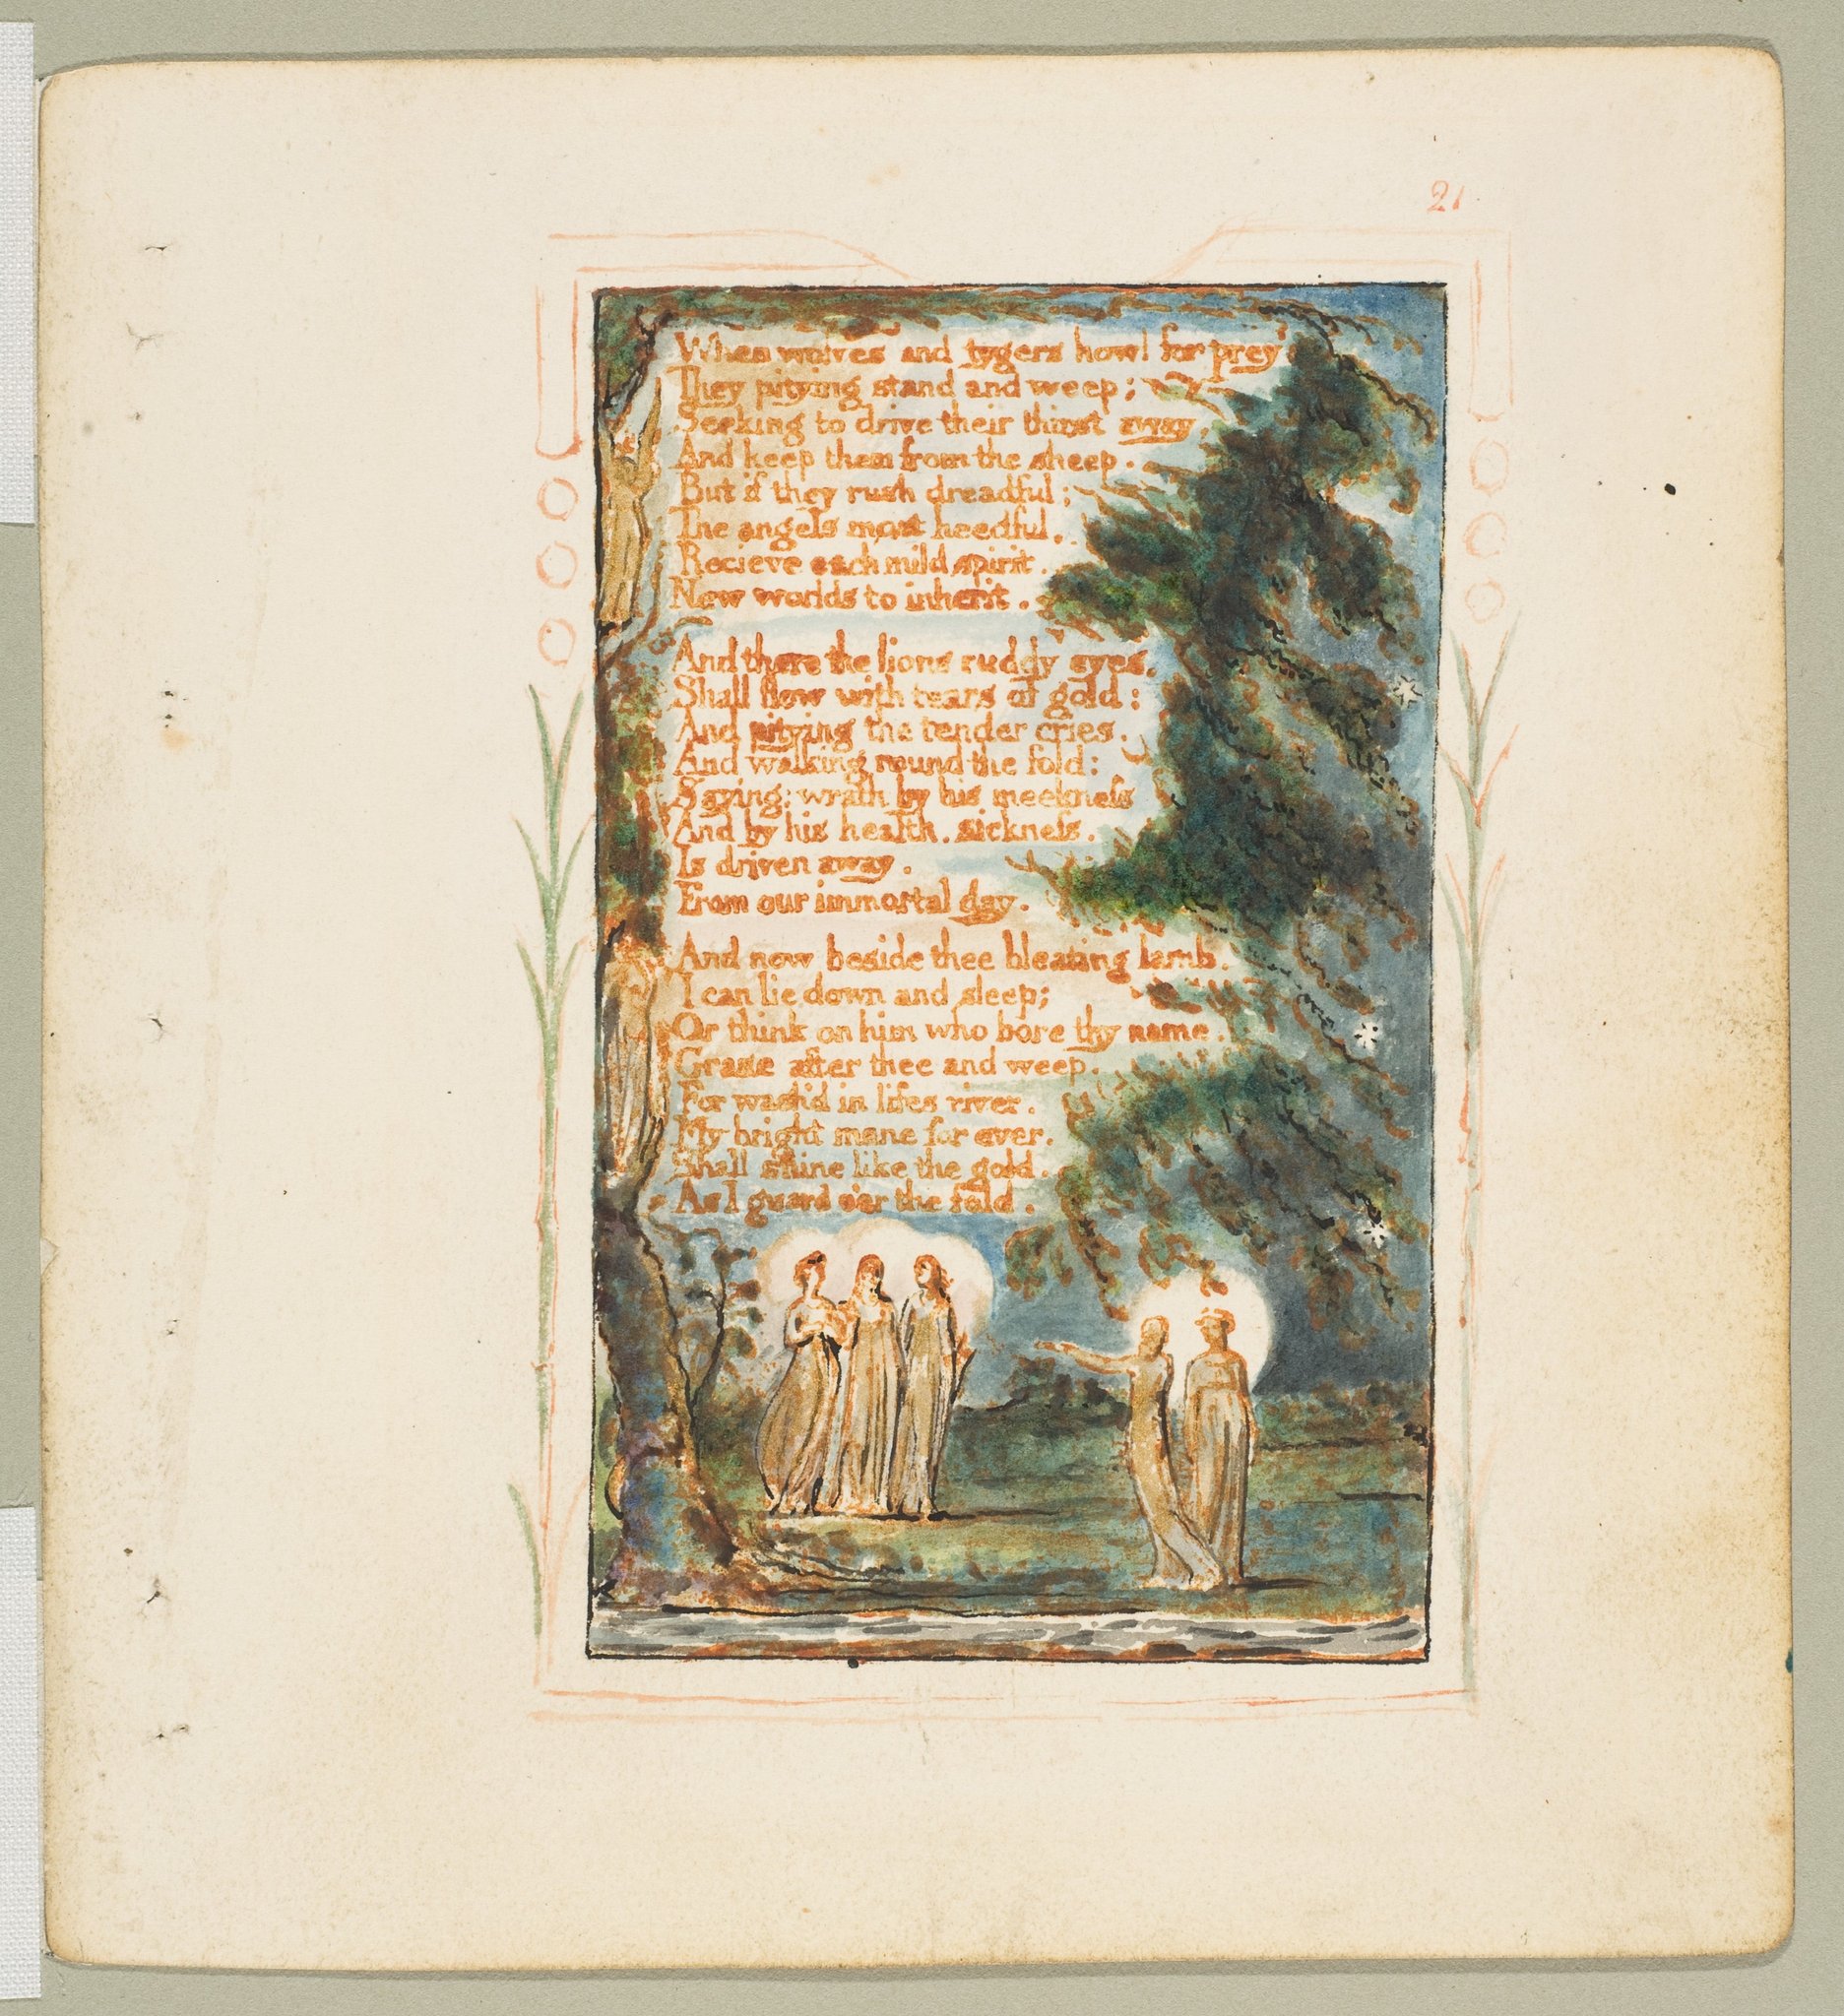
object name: print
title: Songs of Innocence: Night (second plate)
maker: william blake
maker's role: artist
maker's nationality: british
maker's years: 1757-1827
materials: gold, ink, shell, watercolor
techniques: etching, hand coloring, printing, relief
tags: human figures,night